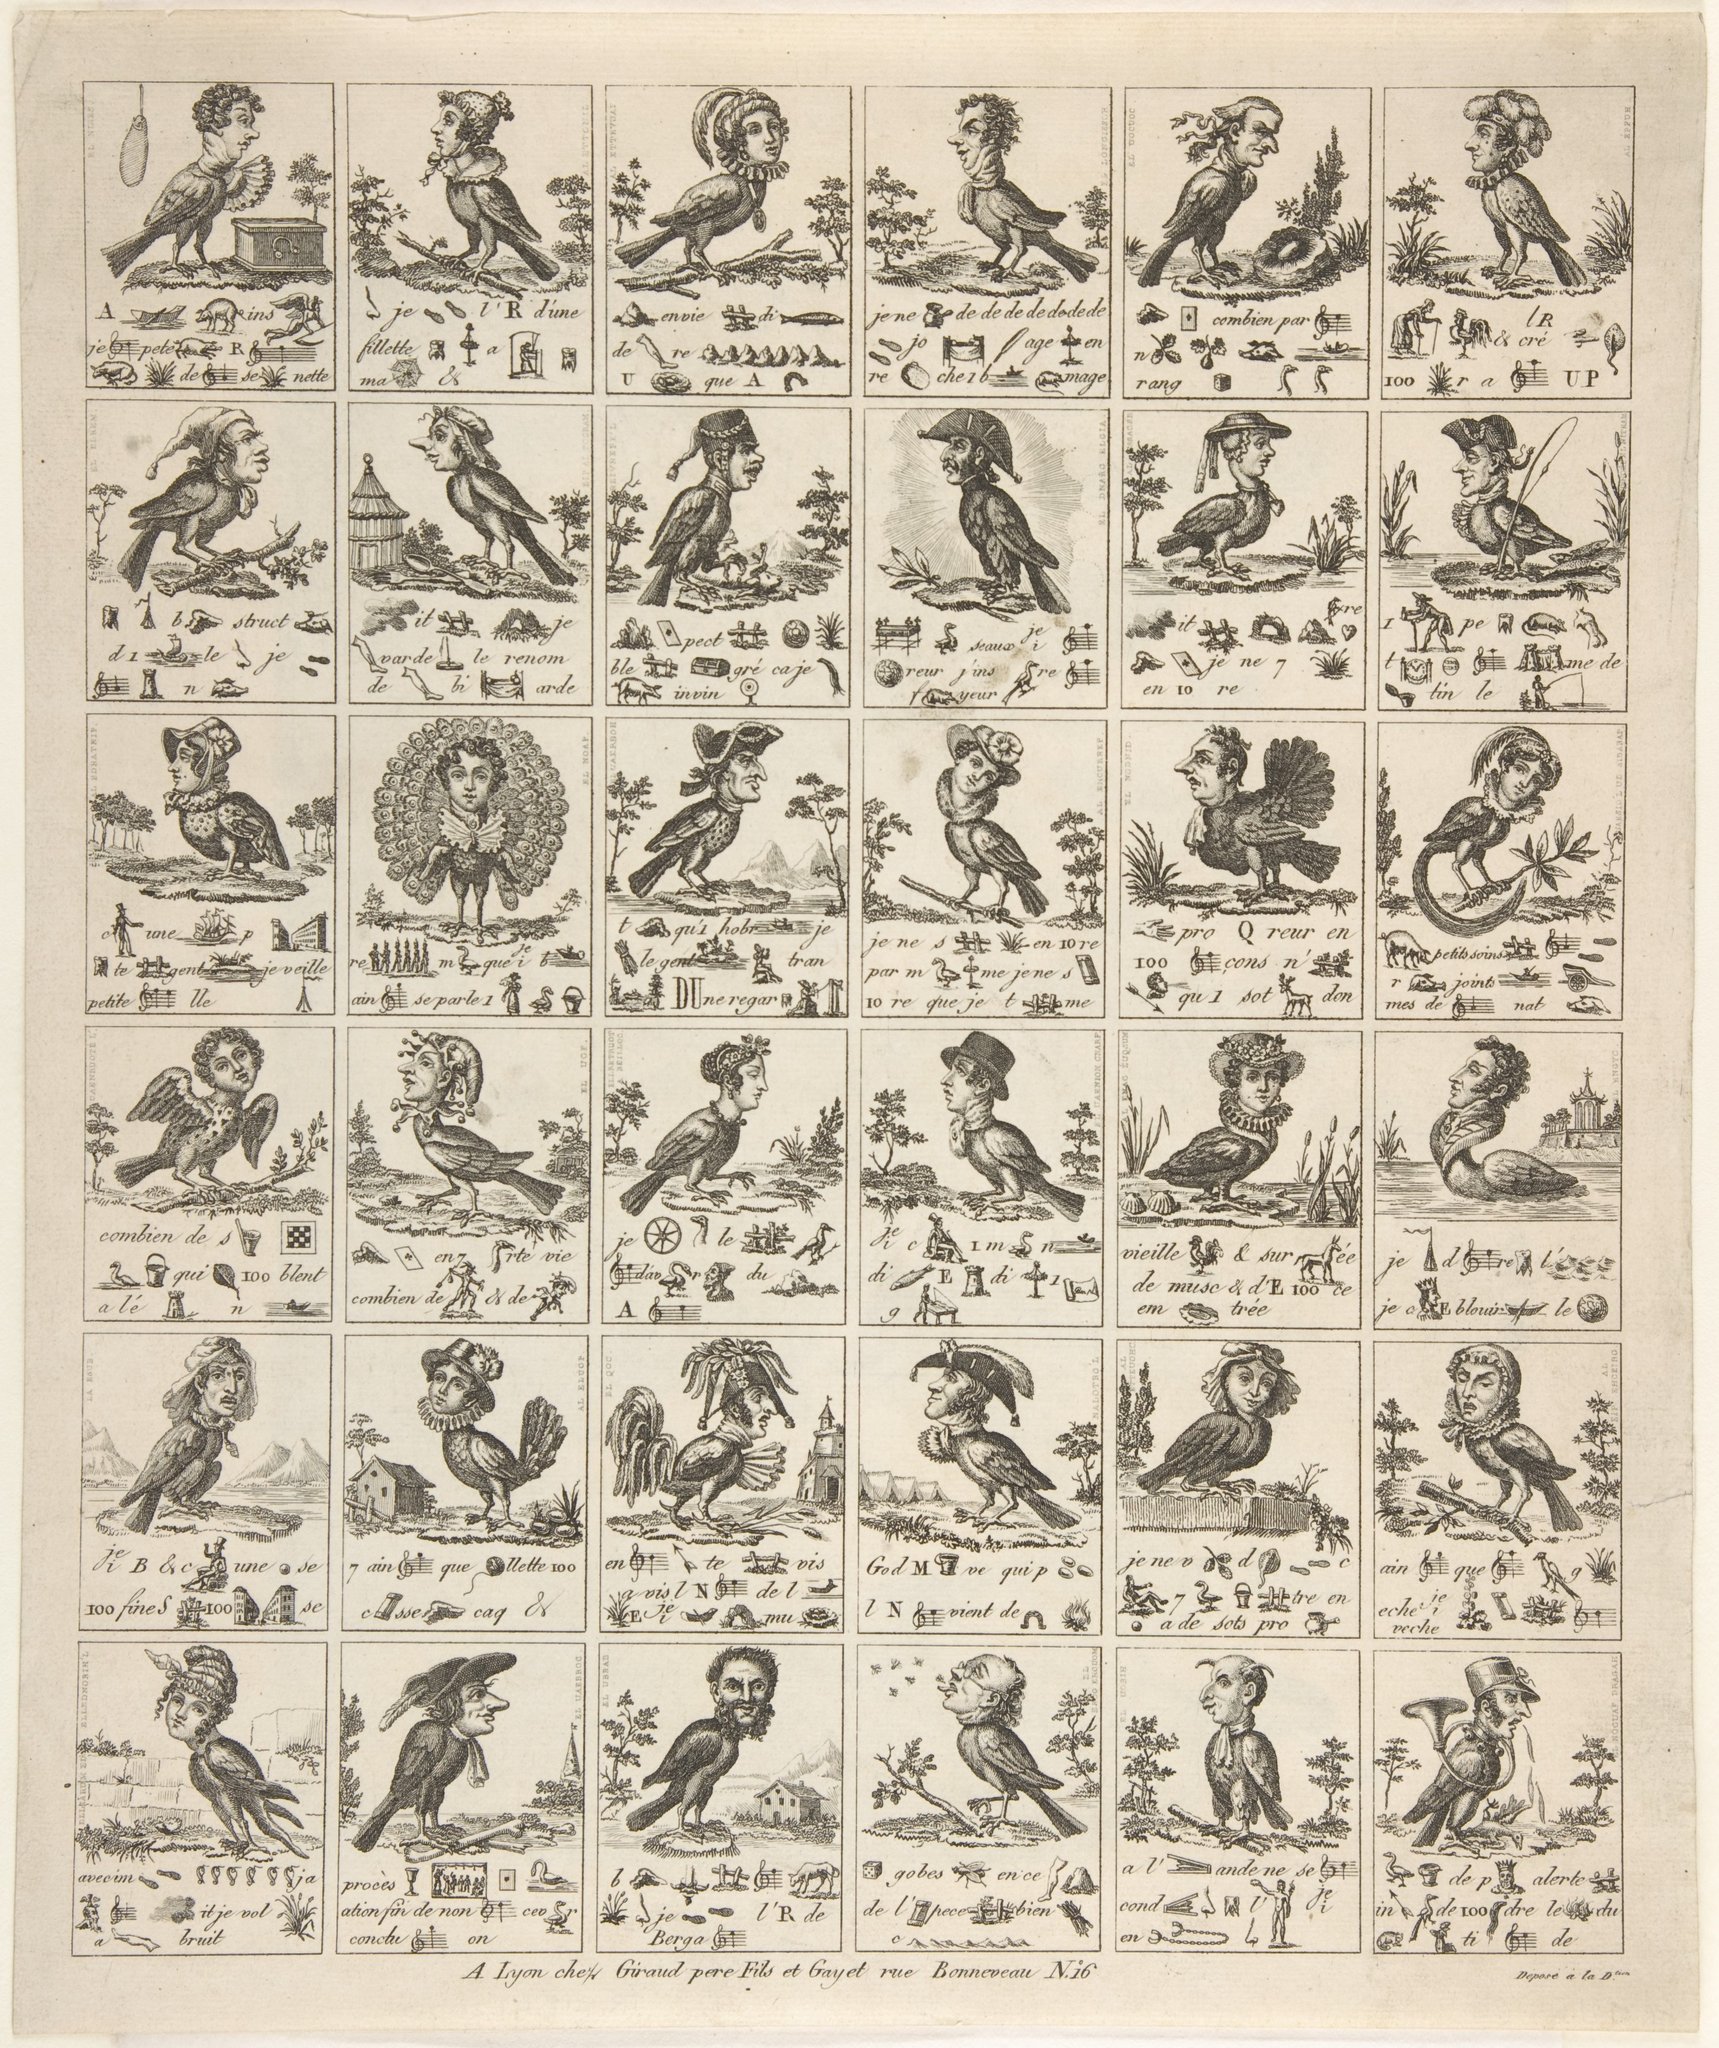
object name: print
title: Sheet of Rebuses with Birds with Human Heads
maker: anonymous, french, 19th century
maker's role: artist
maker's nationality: french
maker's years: 1800-1900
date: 1834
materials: paper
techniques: engraving, etching